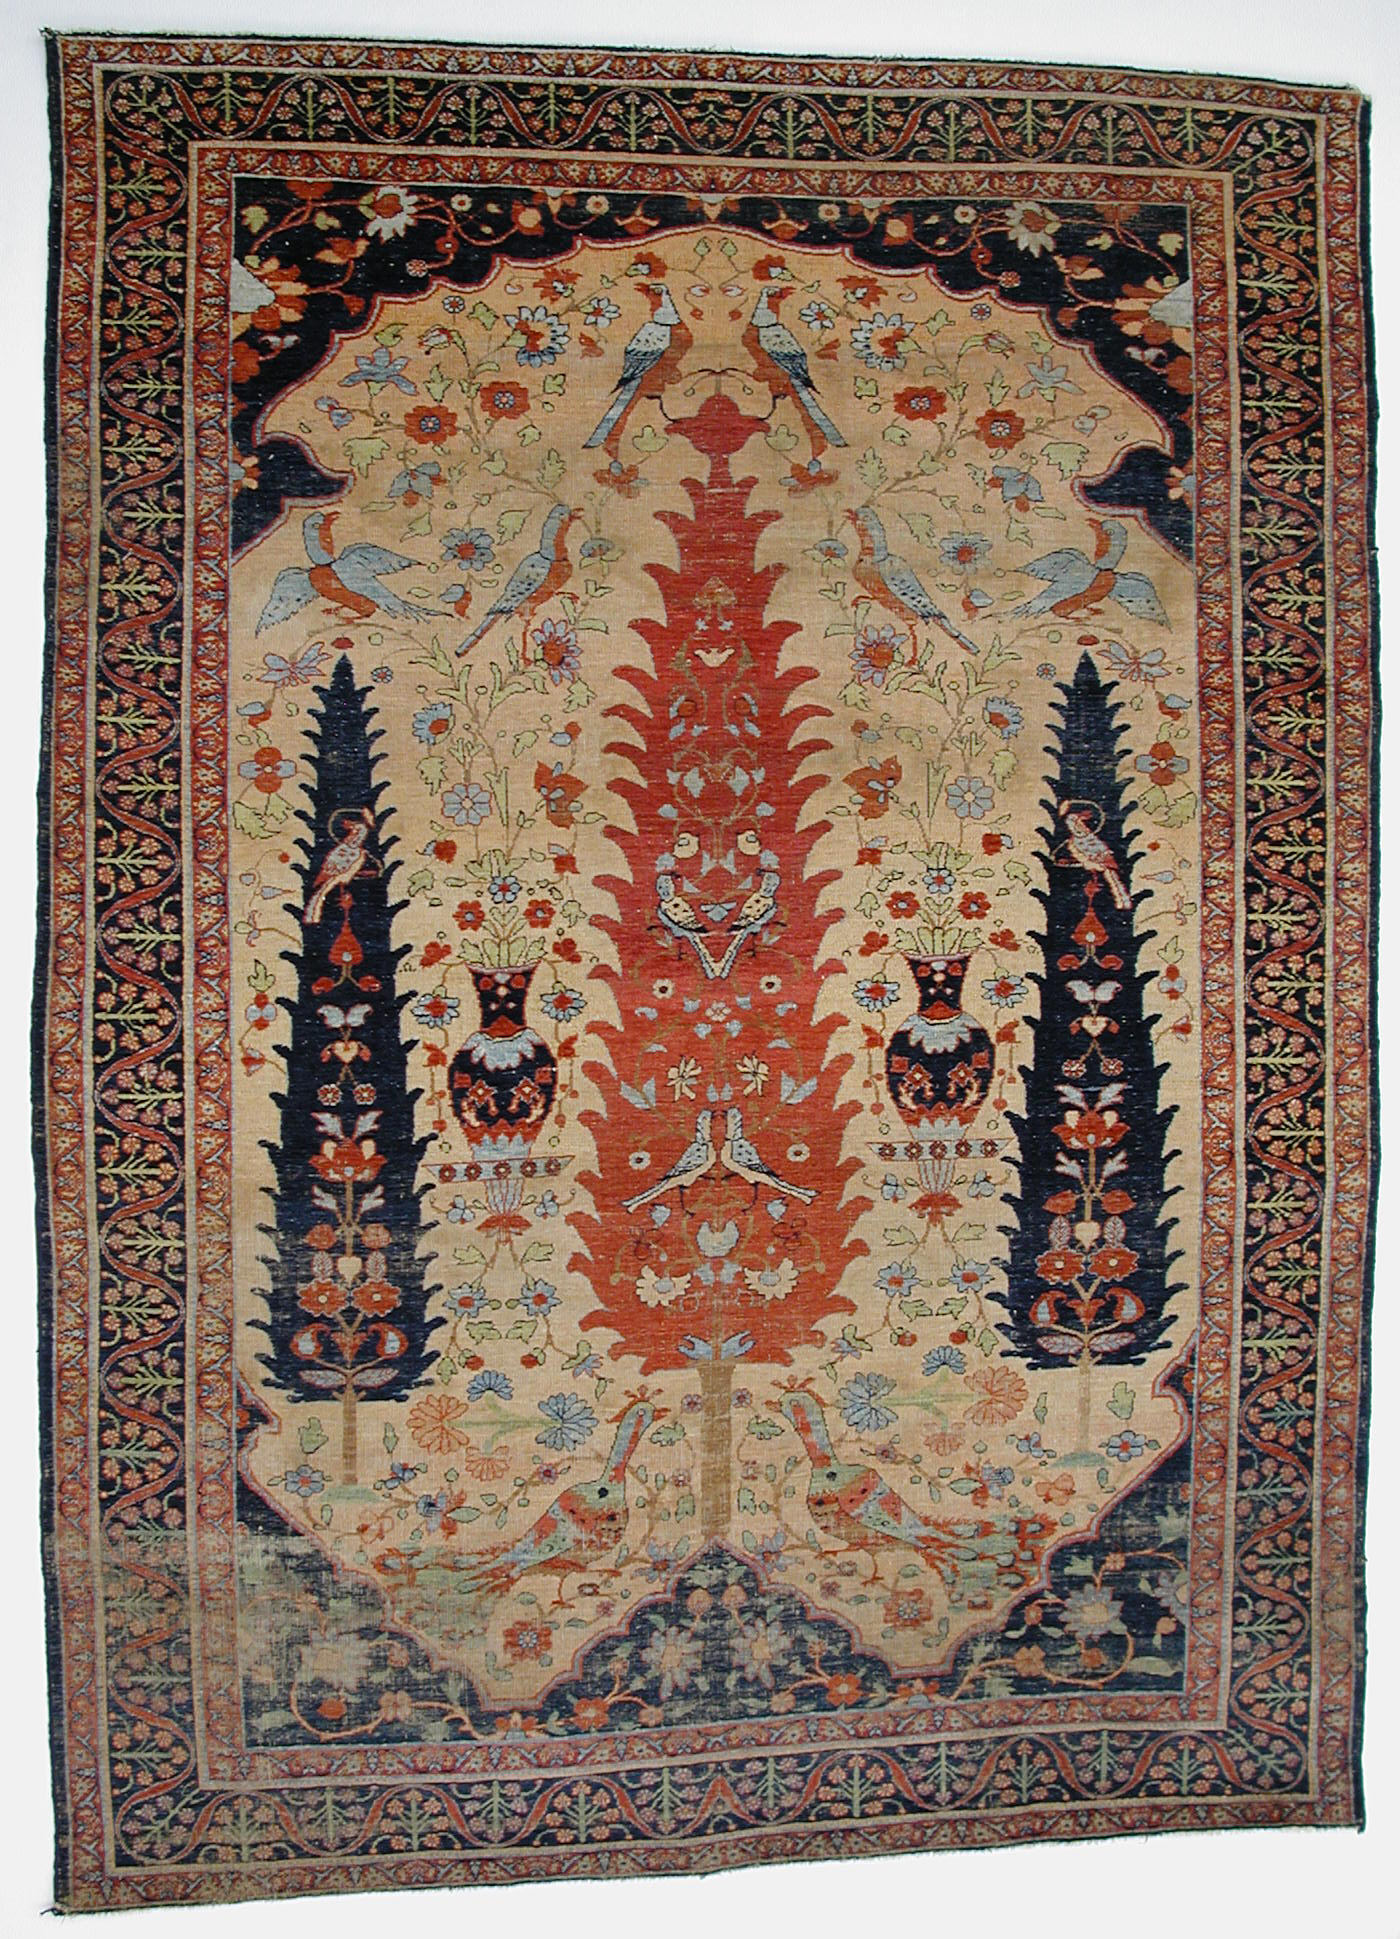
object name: carpet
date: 1767-1800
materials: cotton, silk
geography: iran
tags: birds,flowers,trees